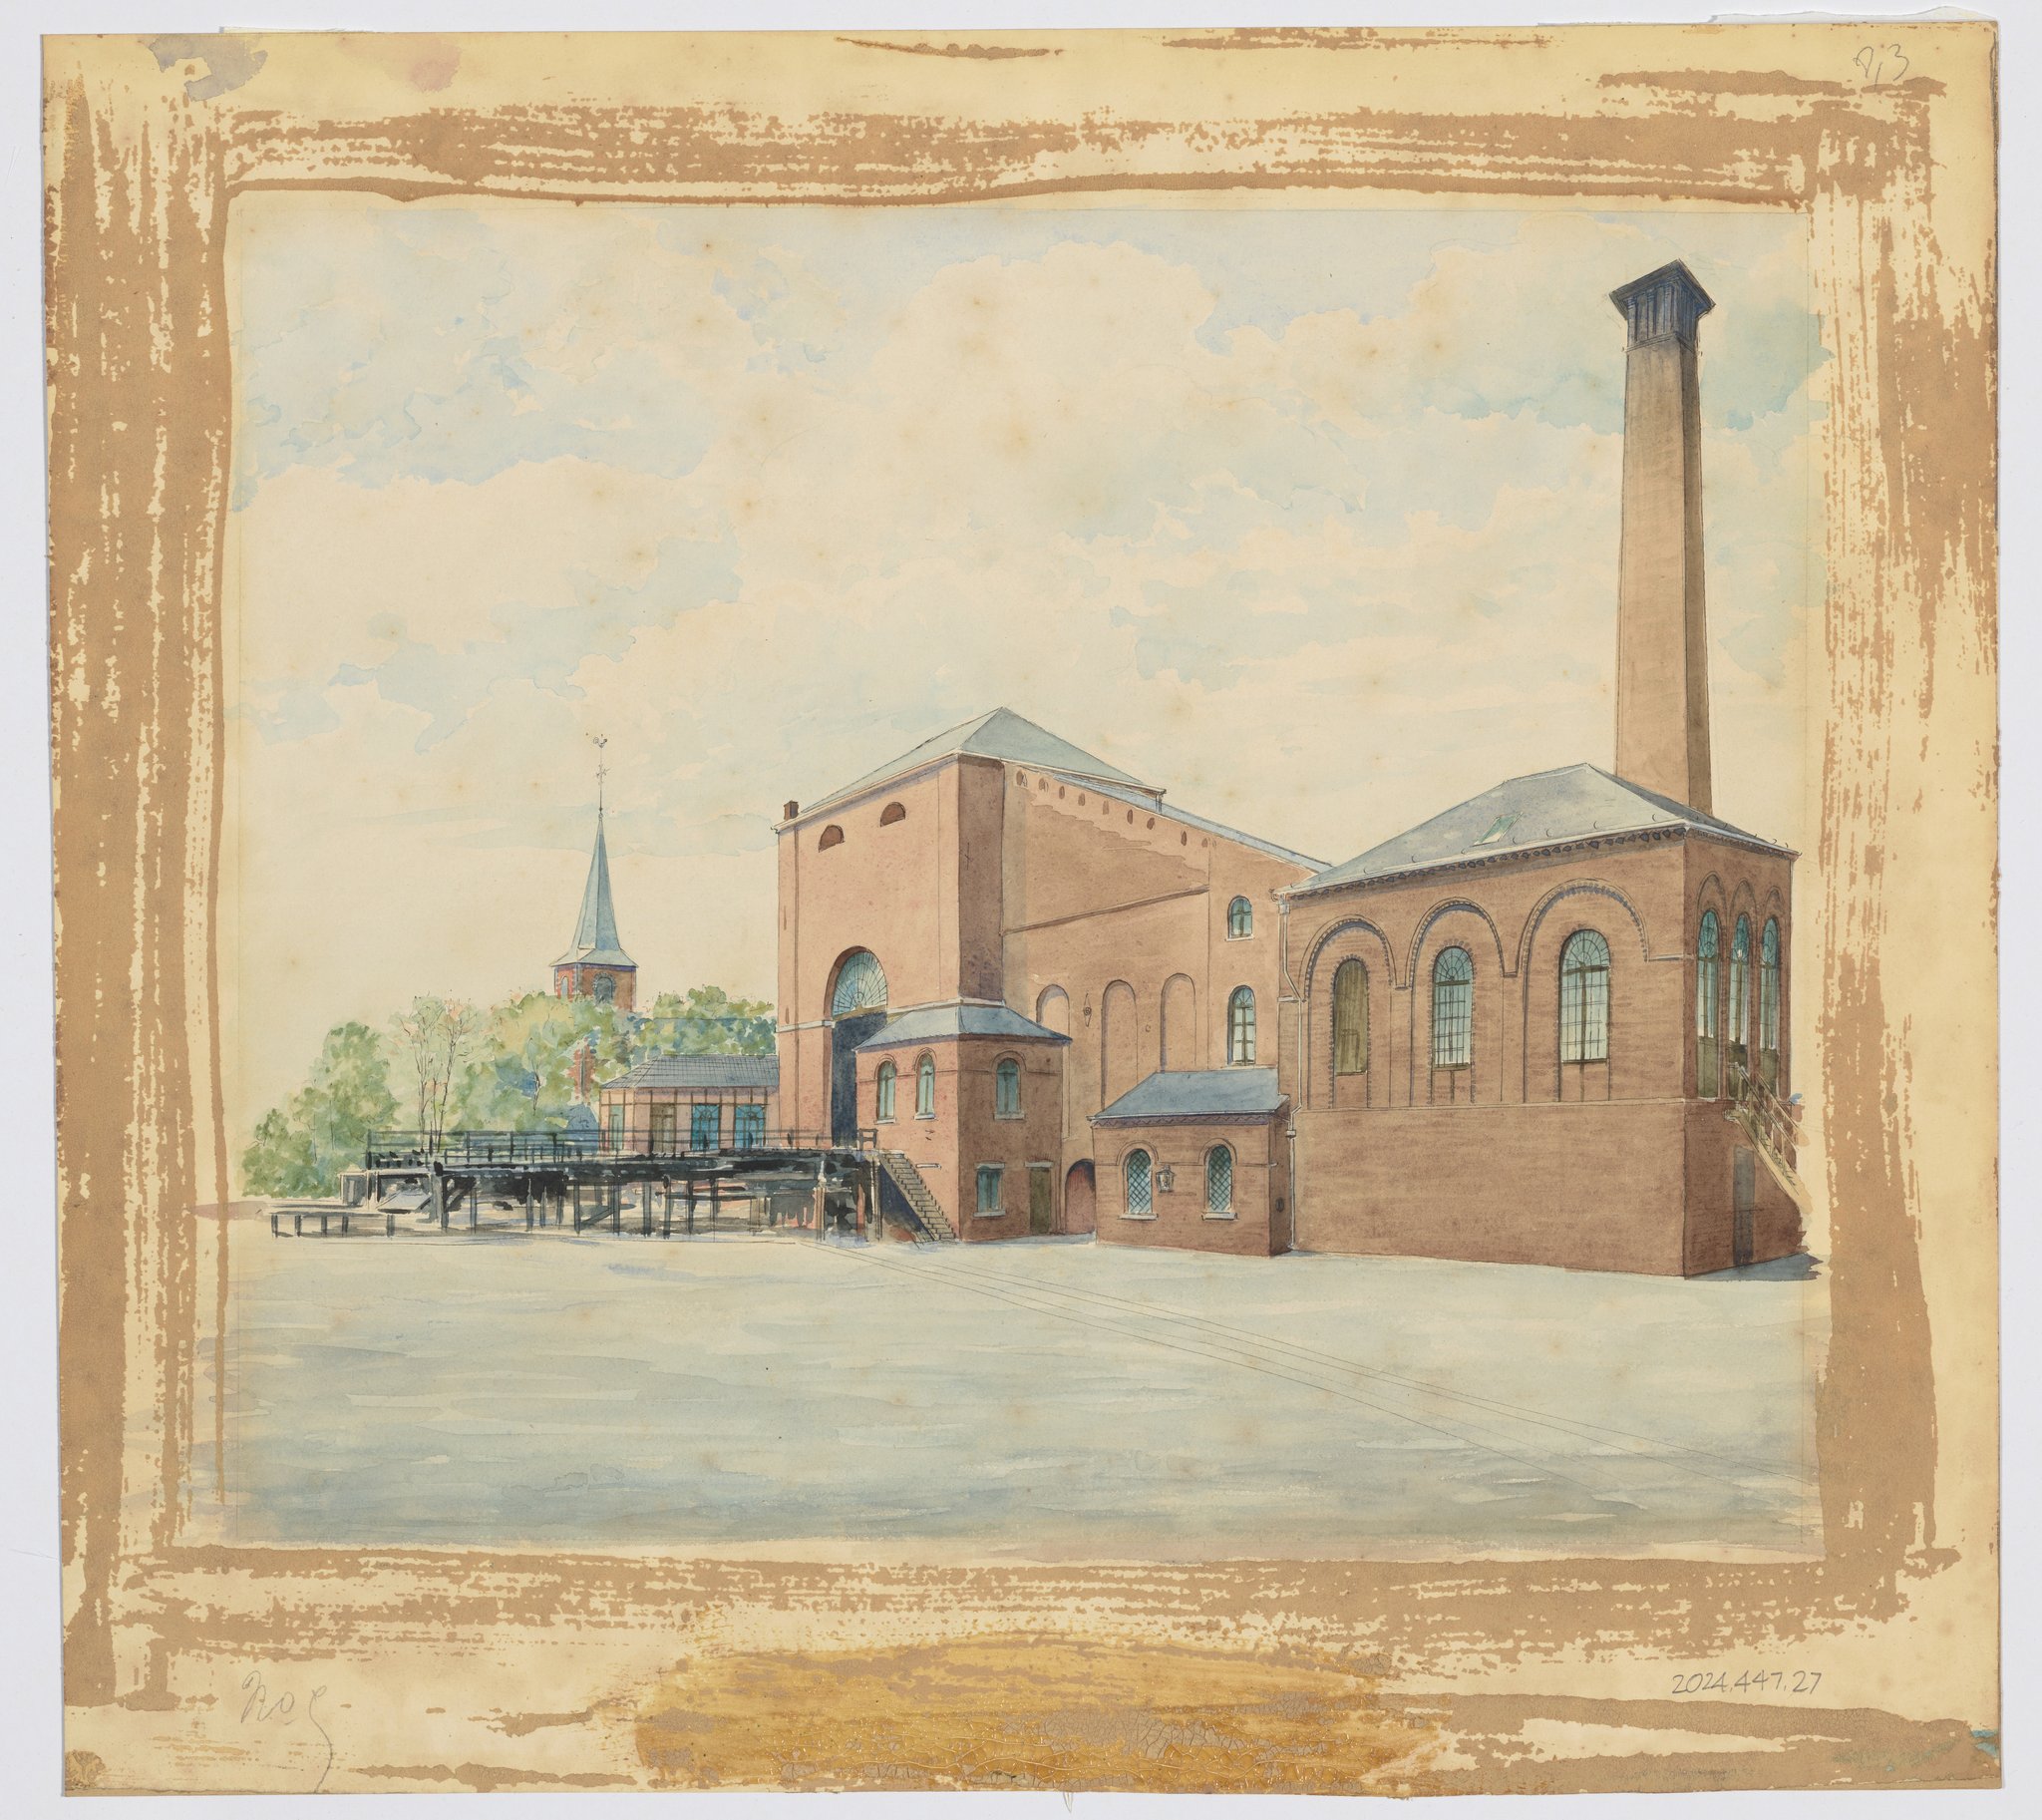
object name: drawing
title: Perspective View from a series of Mines and Factories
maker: th (thomas?) defoiss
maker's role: artist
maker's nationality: french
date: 1905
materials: graphite, ink, watercolor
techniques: pen